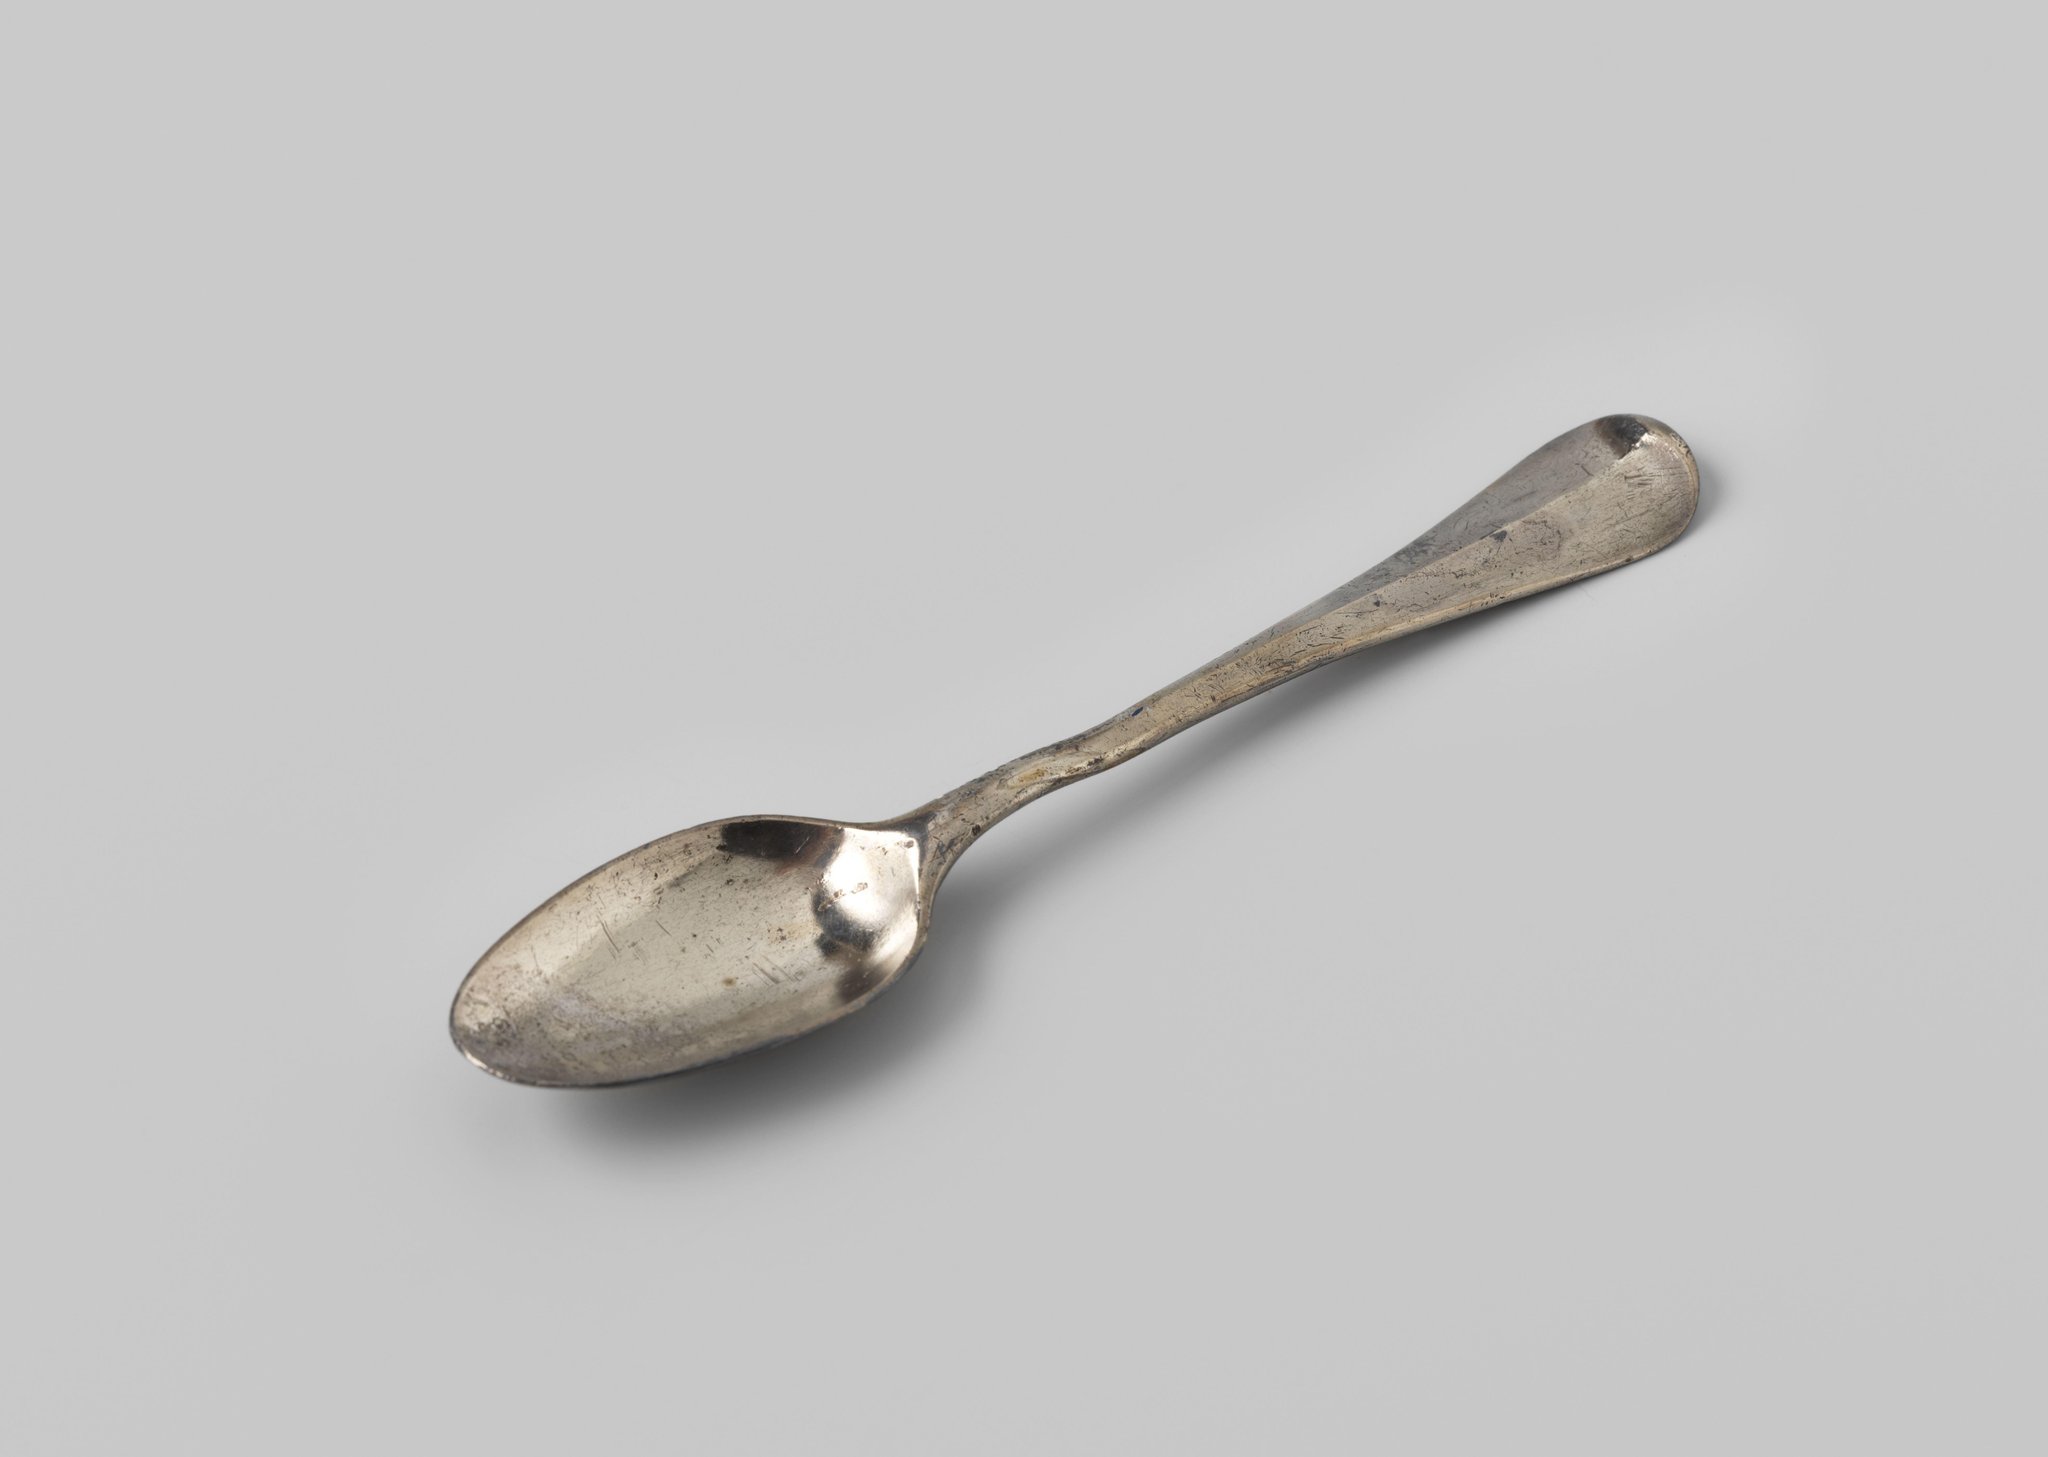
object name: teaspoon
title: Silver teaspoon from the wreck of the Dutch East Indiaman Hollandia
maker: Anonymous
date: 1700-1743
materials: silver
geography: netherlands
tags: verenigde oostindische compagnie, hollandia (schip), annet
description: Teaspoon, stem, flat, widening towards curved end, oval bowl with rat tail on underside, 3 marks [coat of arms of Amsterdam, I, shell], at upper end coat of arms [of van Imhoff-Bentinck].